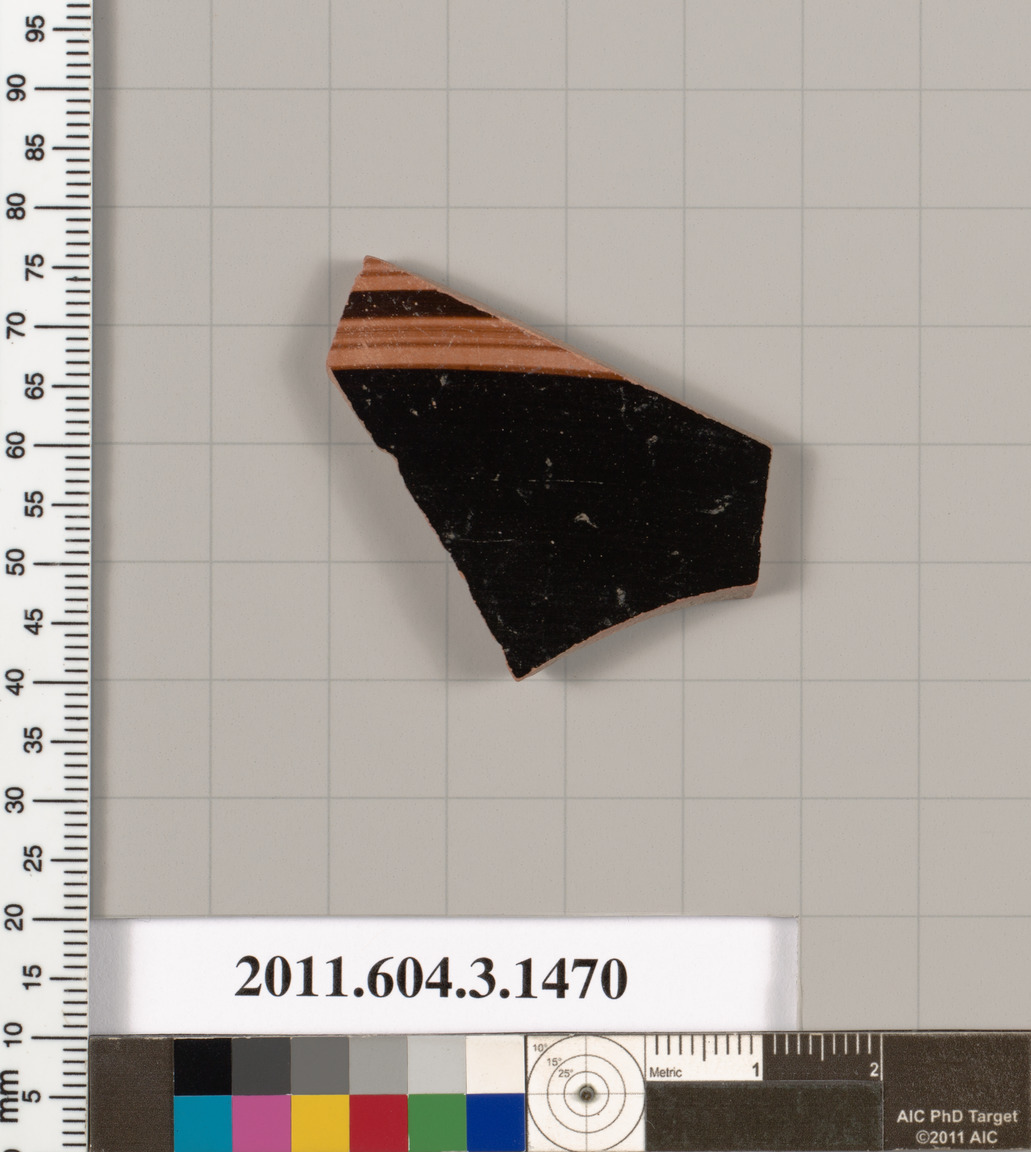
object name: skyphos fragment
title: Terracotta fragment of a skyphos (deep drinking cup)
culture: greek, attic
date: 600-401 BCE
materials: terracotta